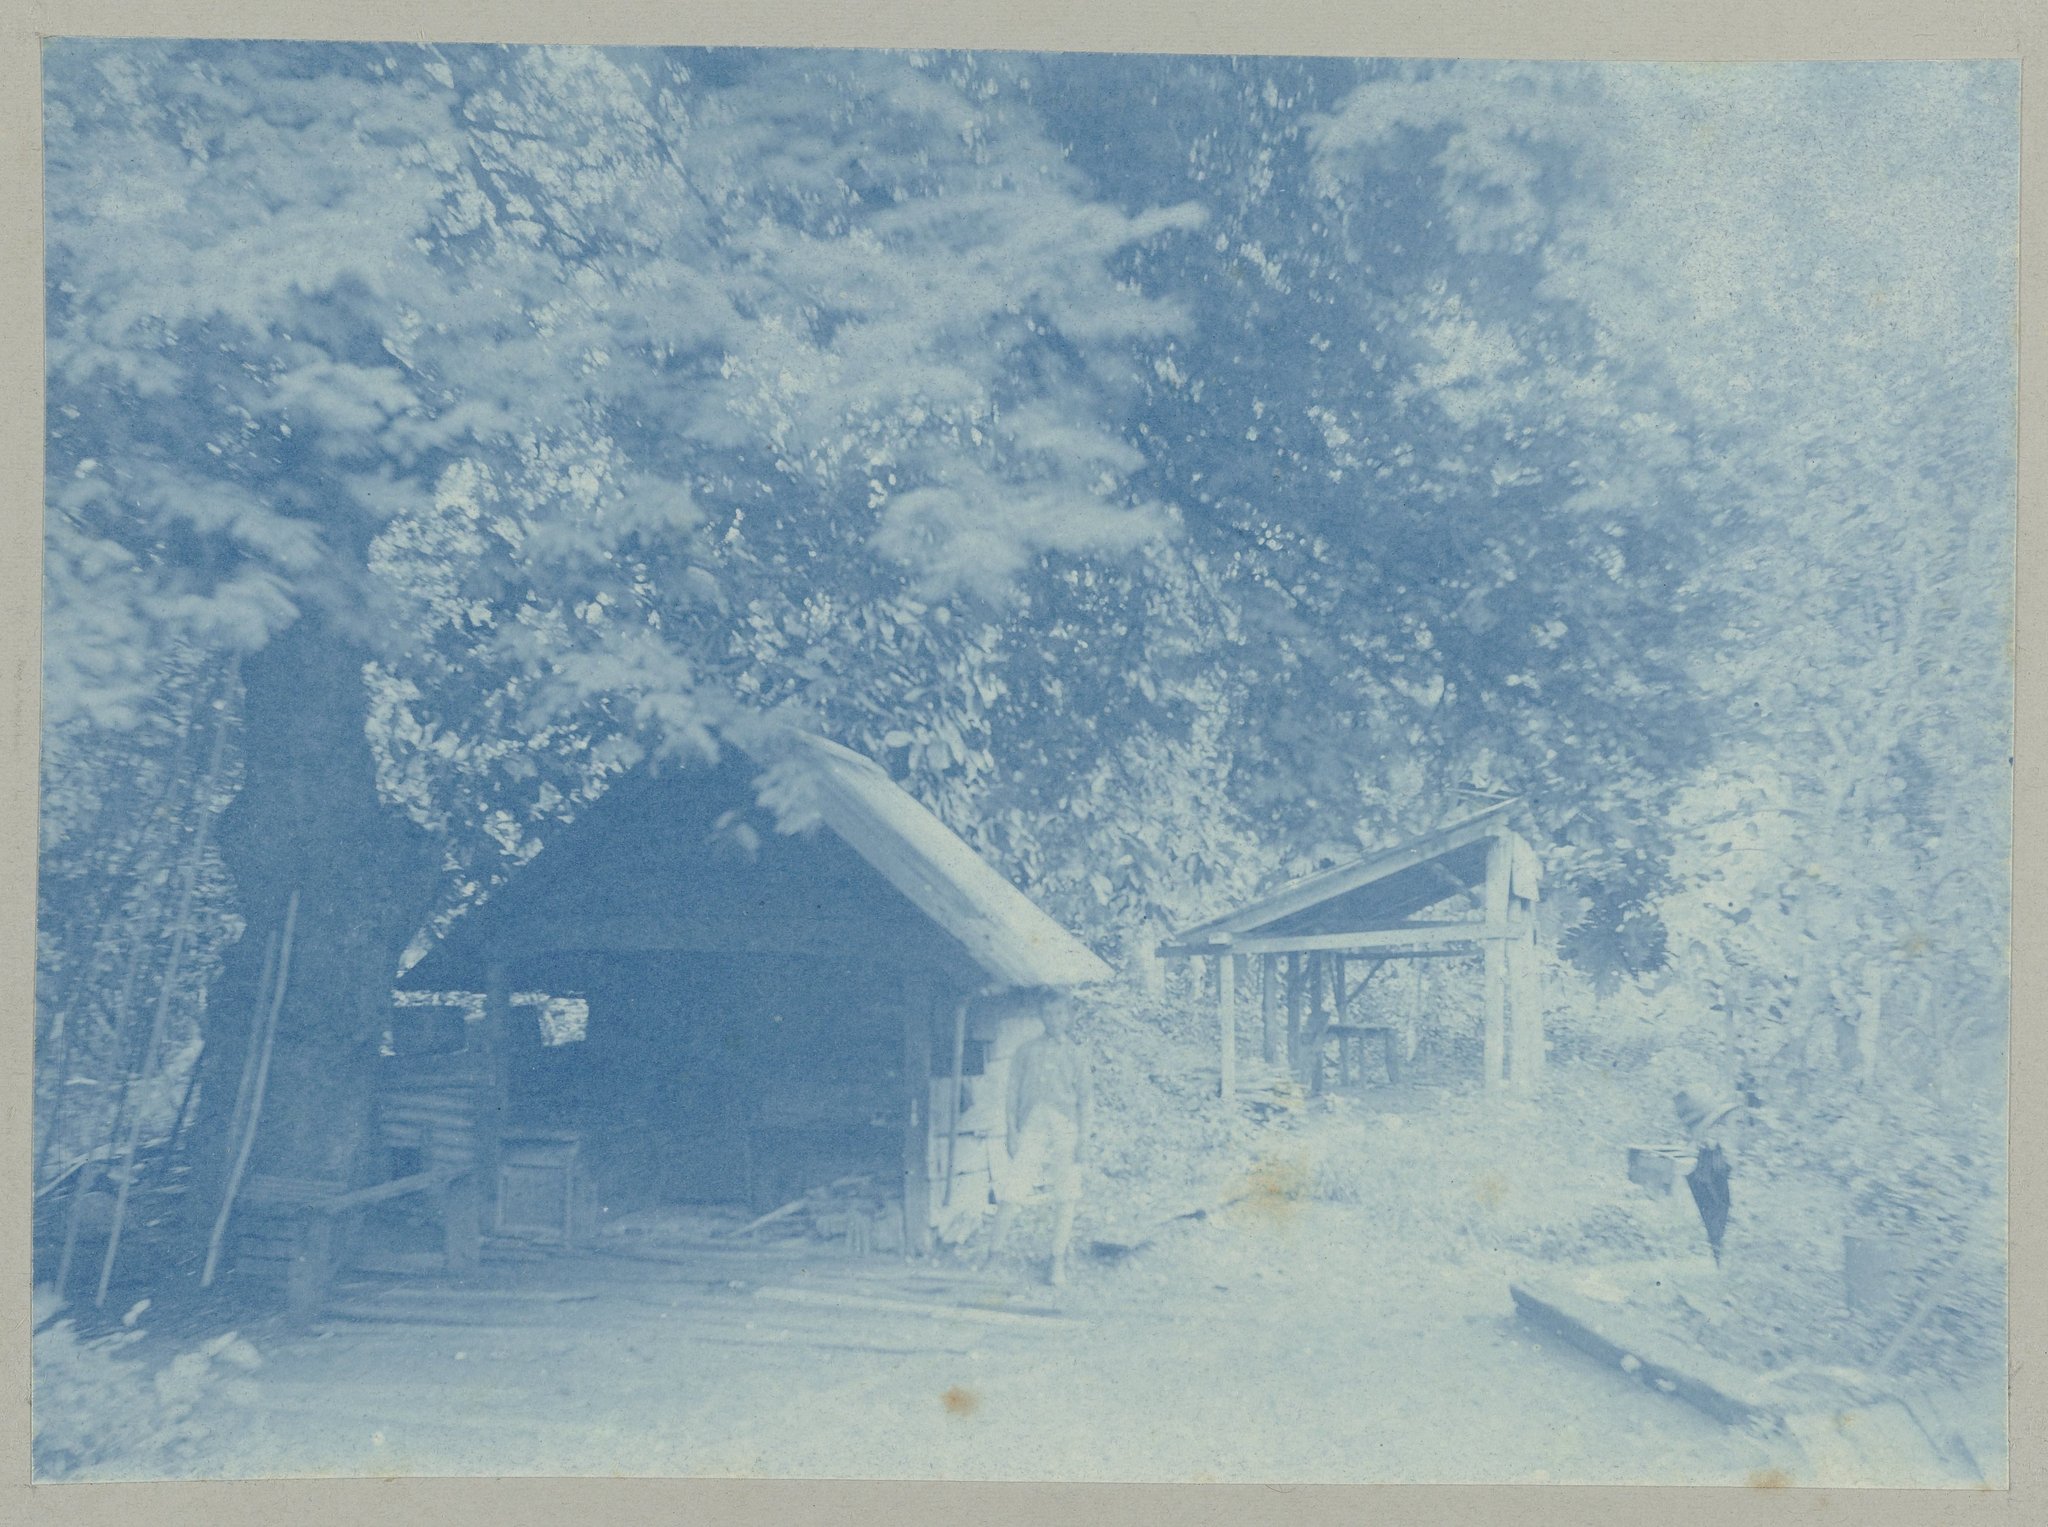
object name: photograph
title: Anton bij wachterskamp op Ma retraite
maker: hendrik doijer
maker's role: engineer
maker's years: 1863-1925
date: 1903-1910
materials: photographic support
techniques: cyanotype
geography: suriname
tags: suriname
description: Nederlandse jongen genaamd Anton staande bij een hut van het wachterskamp op de plantage Ma retraite. Onderdeel van het fotoalbum Souvenir de Voyage (deel 2), over het leven van de familie Doijer in en rond de plantage Ma Retraite in Suriname in de jaren 1903-1910.